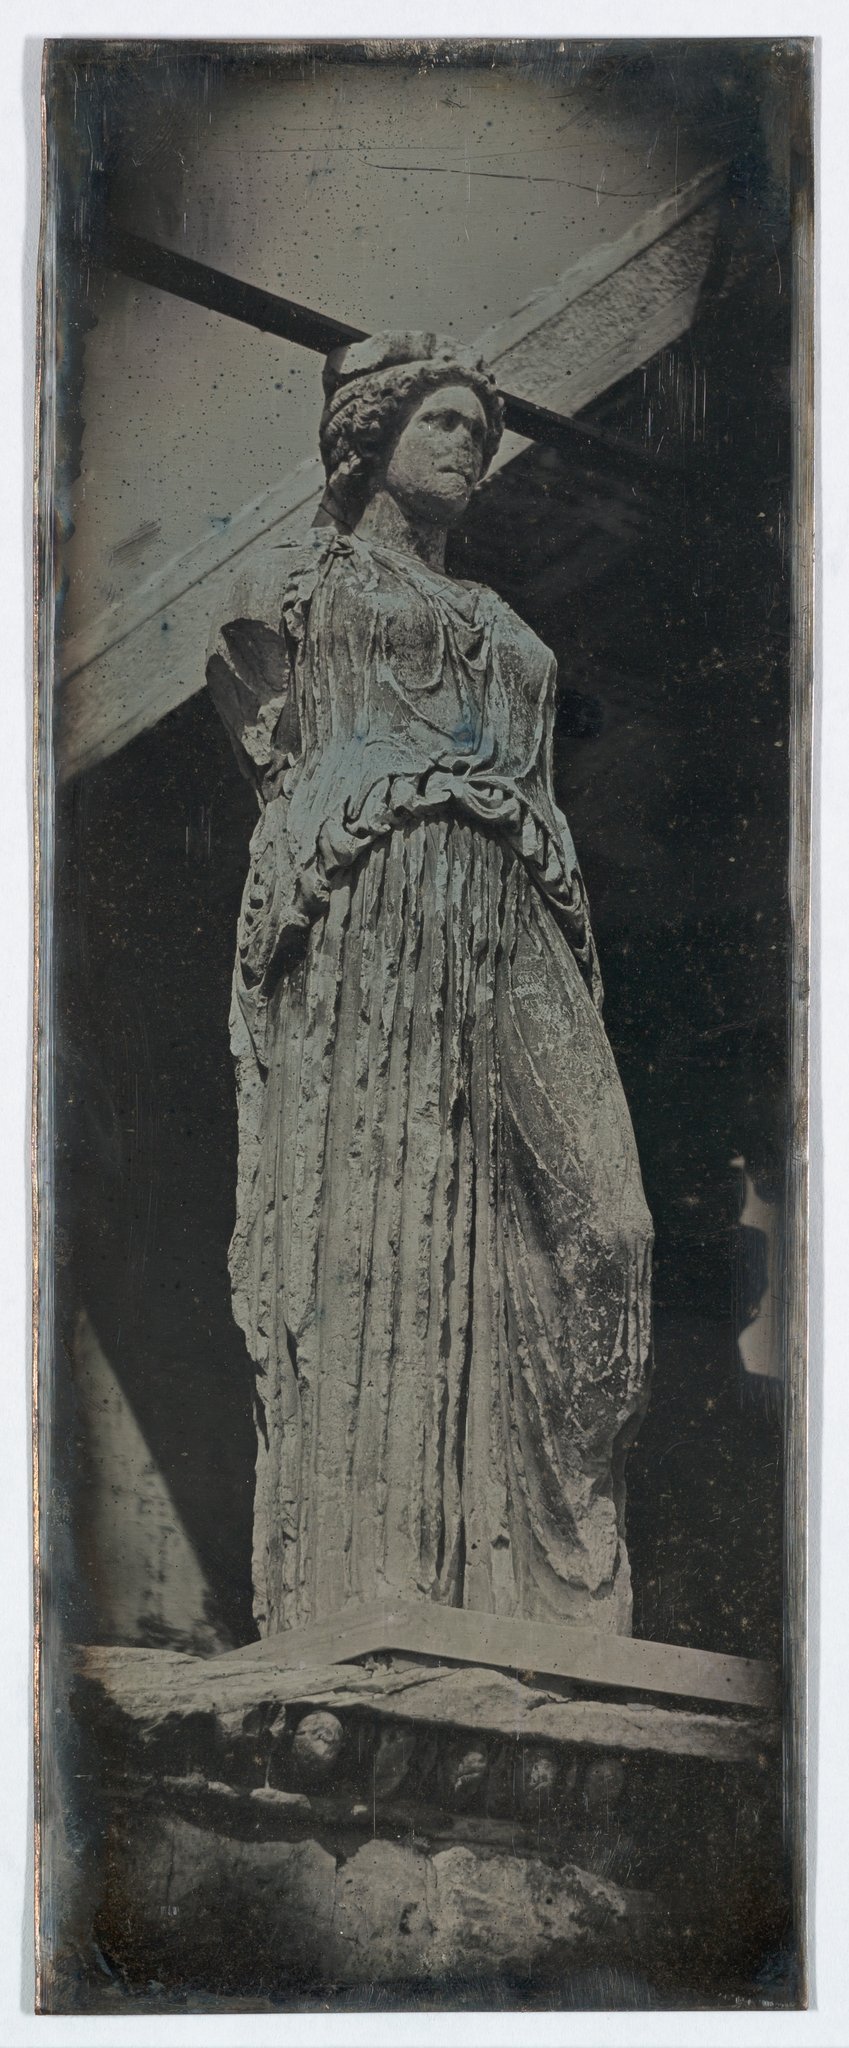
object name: photograph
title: Caryatid, Erechtheion, Athens (56. Athènes. Caryatides. Erecht.)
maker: joseph-philibert girault de prangey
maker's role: artist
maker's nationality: french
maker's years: 1804-1892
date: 1842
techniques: daguerreotype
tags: sculpture,caryatids